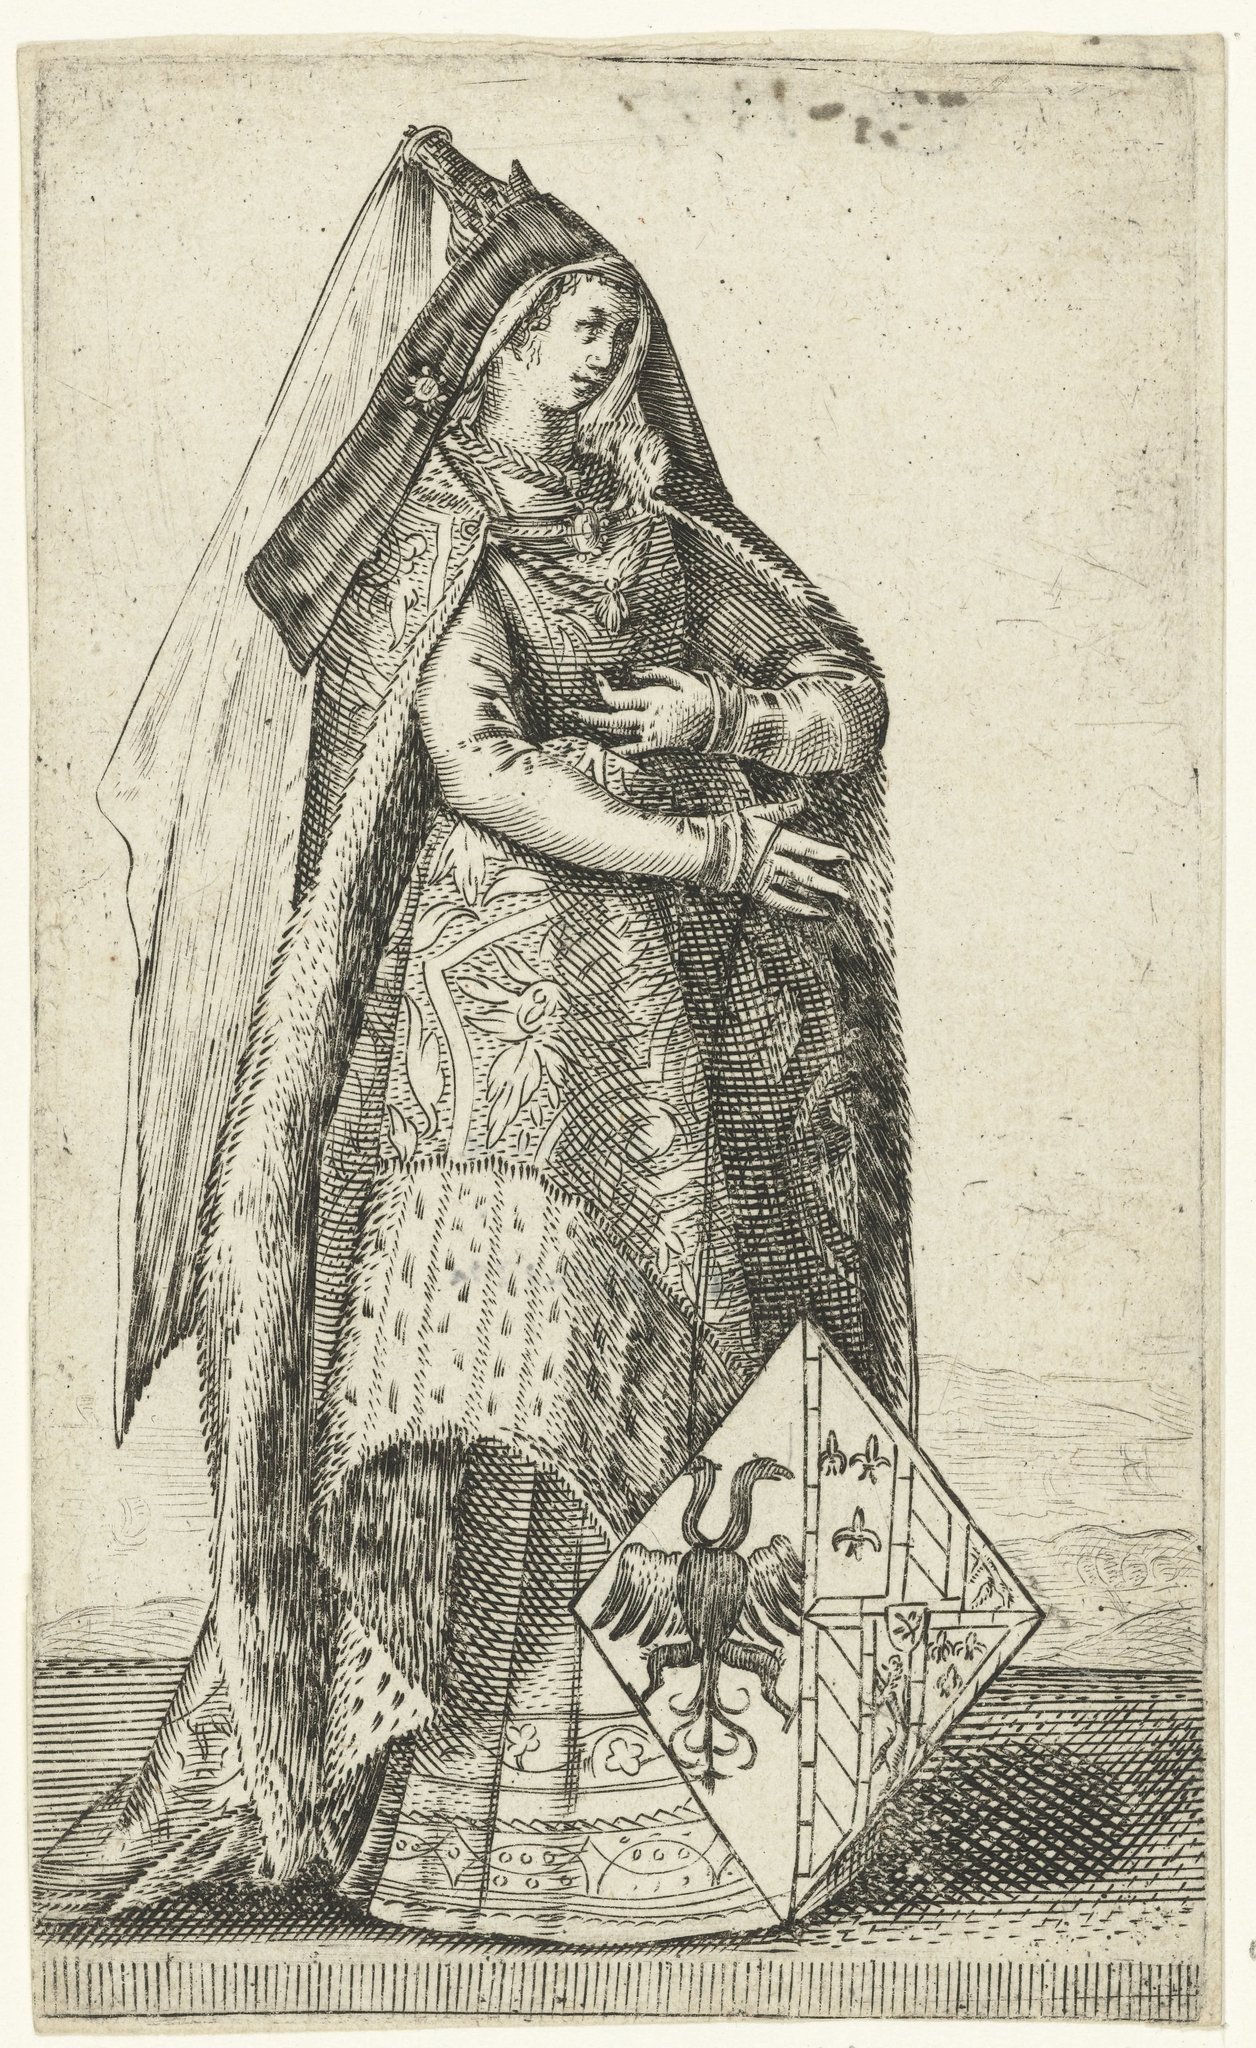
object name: print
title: Portret van Maria, hertogin van Bourgondië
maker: adriaen matham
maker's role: draughtsman, print maker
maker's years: 1599-1660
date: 1620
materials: paper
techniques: engraving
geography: haarlem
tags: brussels, bruges, maria (hertogin van bourgondië), nobility and patriciate; chivalry, knighthood, county of holland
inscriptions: collector's mark: Lugt 2228, name: ‘vrouw maria/ 27ste gravin’, number: ‘1477’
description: Prent ook gebruikt in: Het oude Goutsche chronycxken van Hollandt, Zeelandt, Vrieslandt, en Vtrecht. [bewerkt door] P. Scriverius. Amsterdam: J.H. Boom, J. Pluymer and C. Commelĳn, 1663.